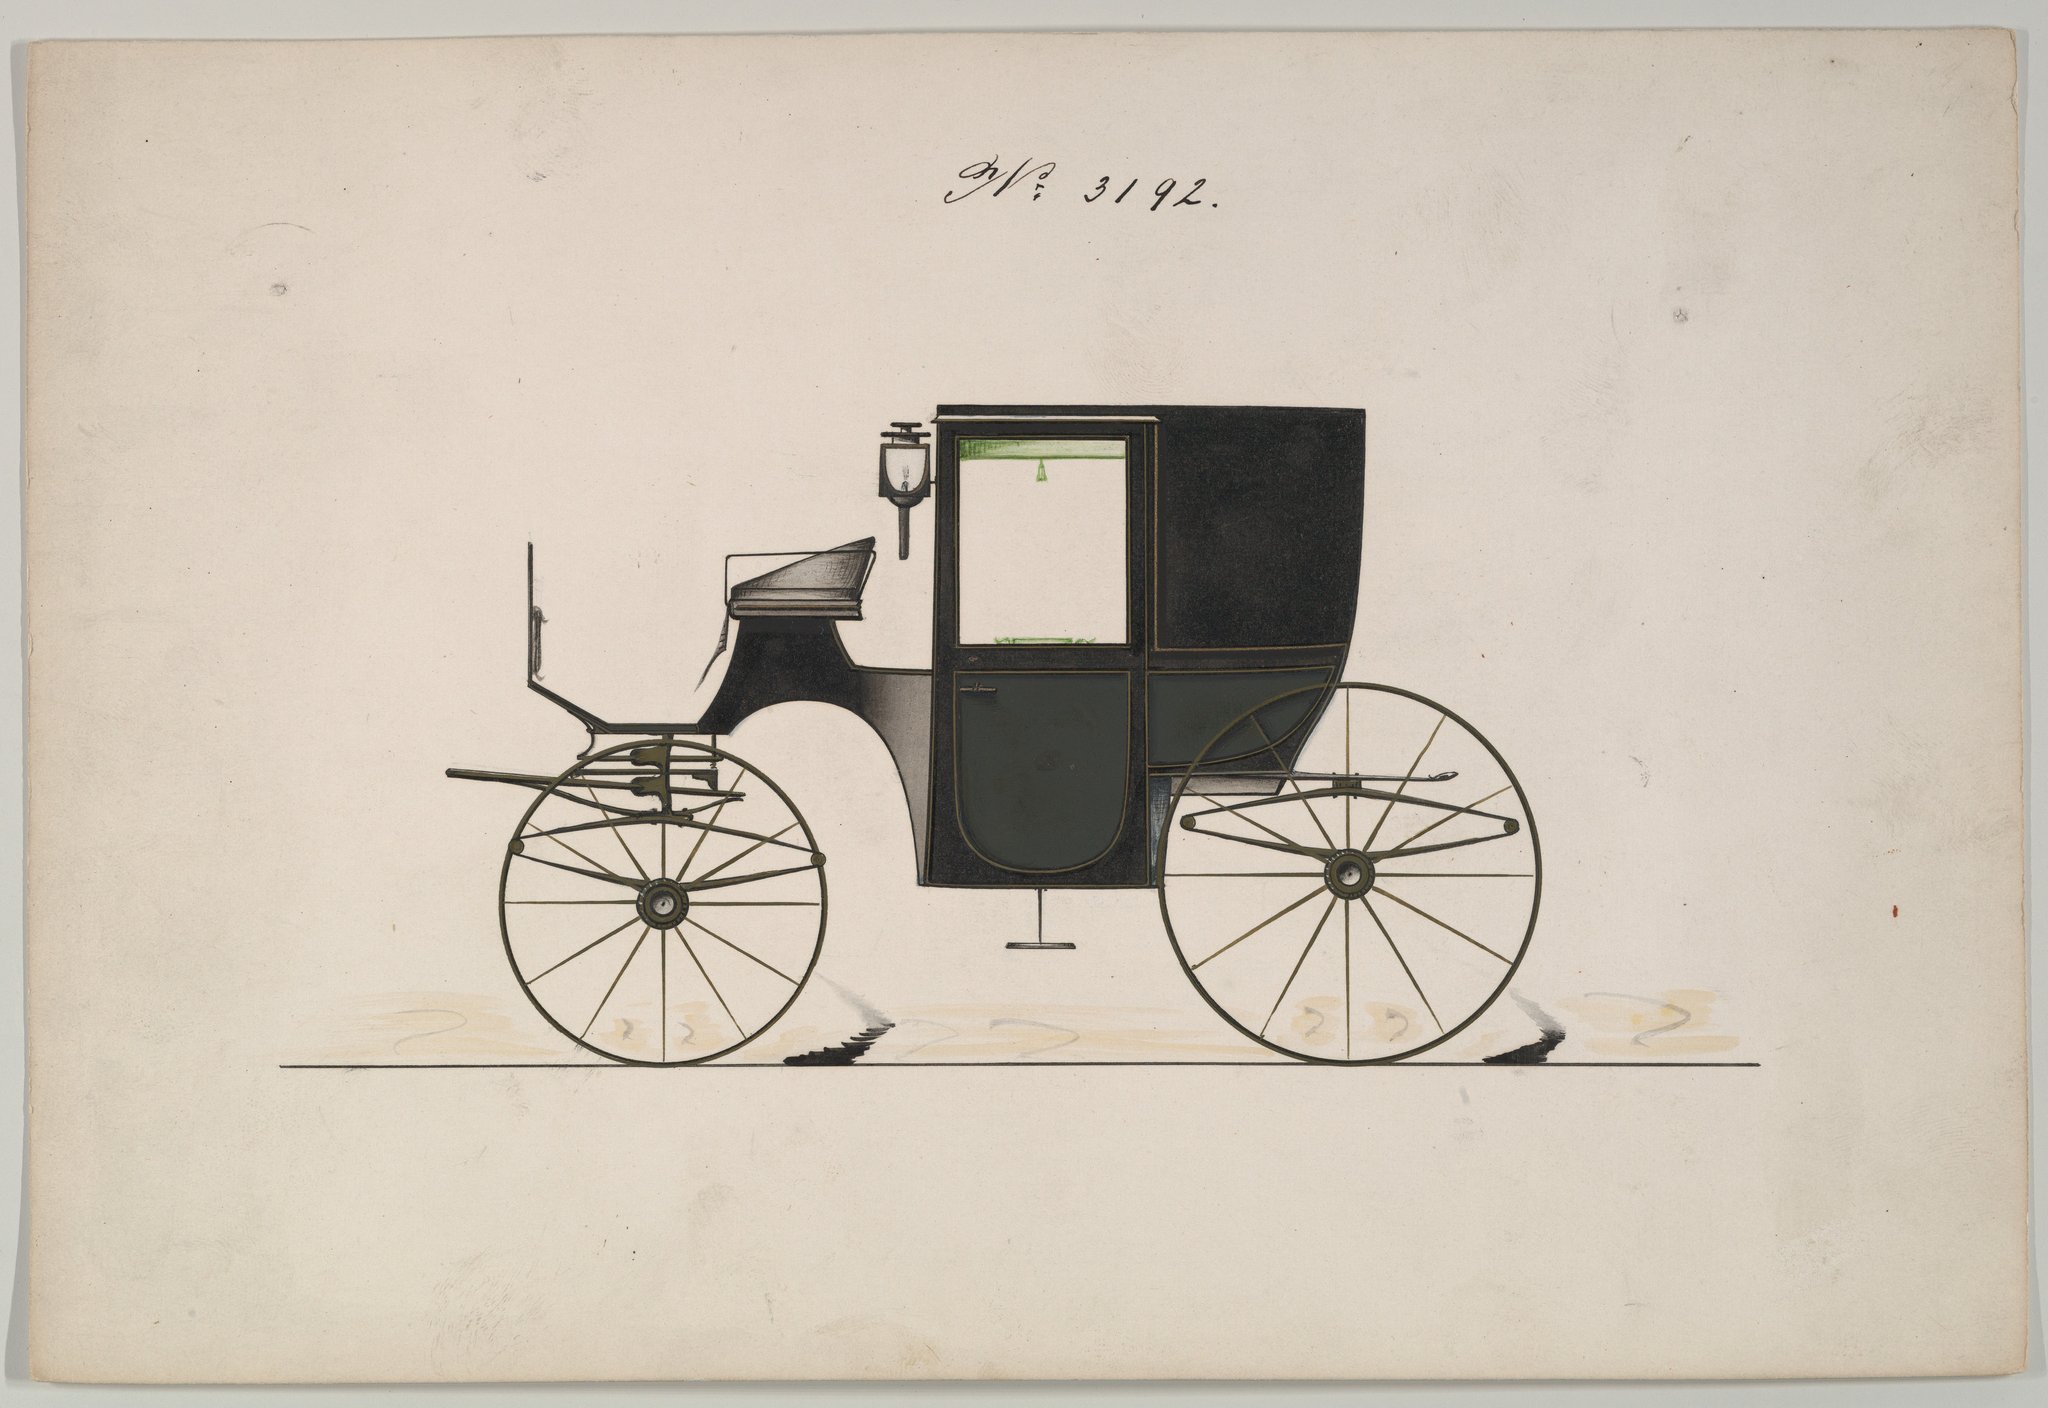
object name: drawing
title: Brougham #3192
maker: brewster & co.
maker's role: manufacturer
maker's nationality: american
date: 1876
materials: gouache, gum arabic, ink, watercolor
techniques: pen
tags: carriages